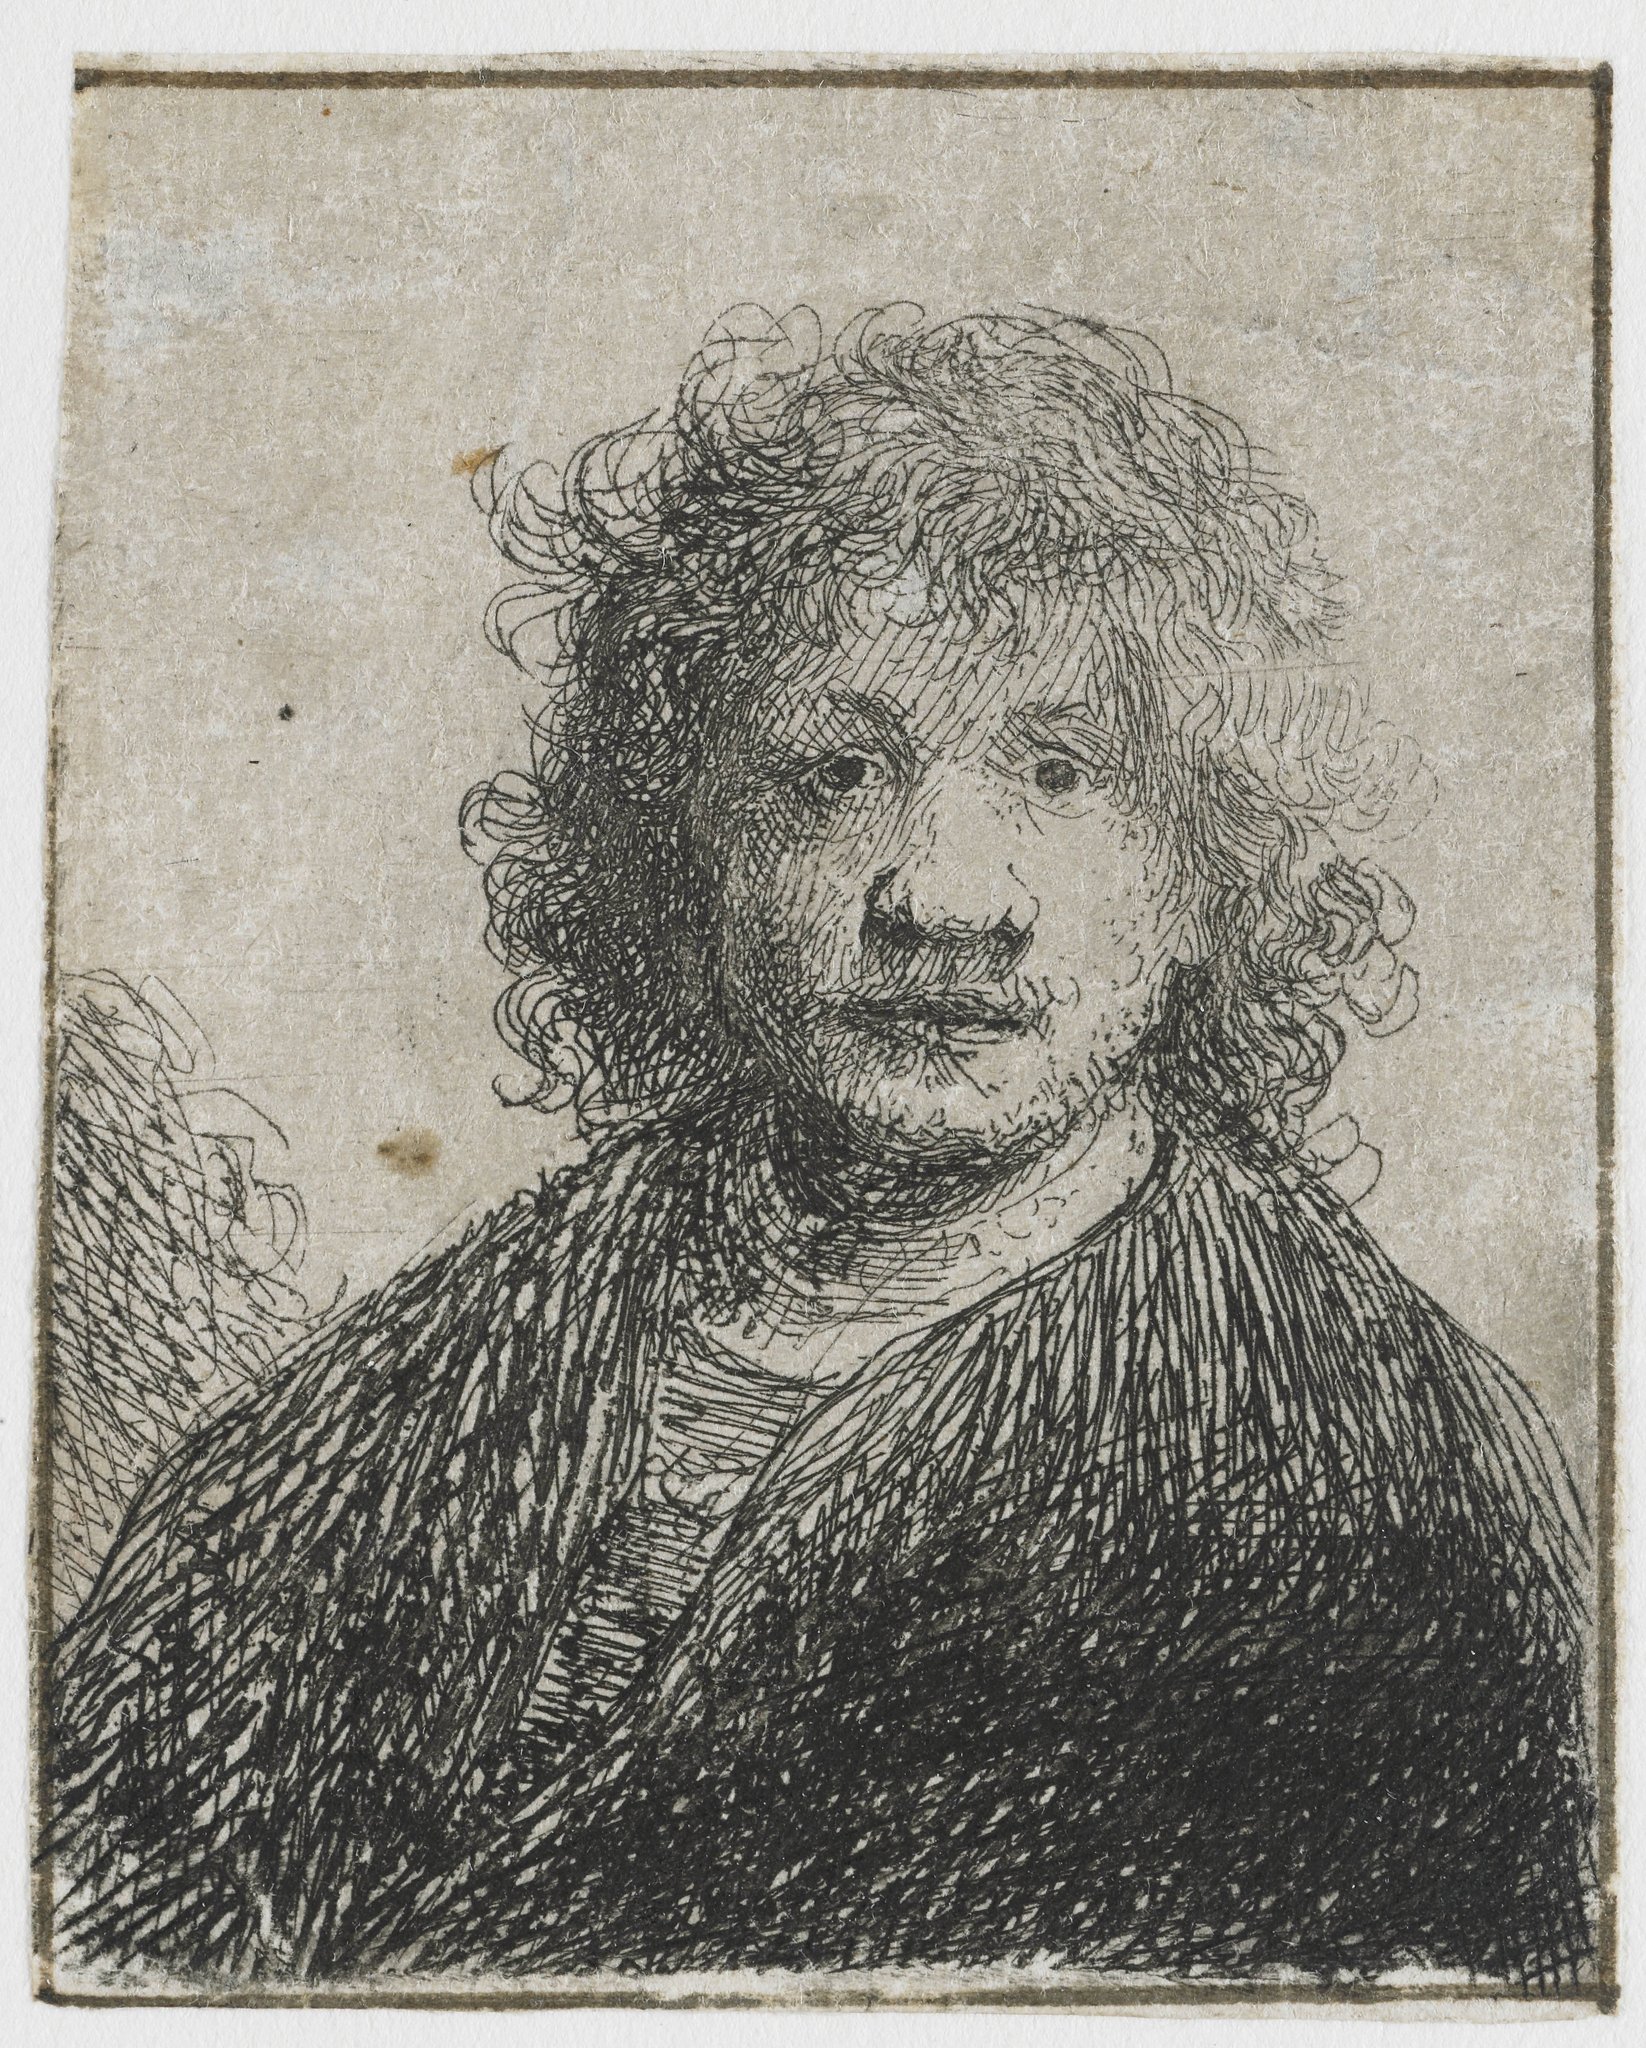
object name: print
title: Self-portrait with a broad nose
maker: rembrandt van rijn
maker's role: draughtsman, painter, print maker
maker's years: 1606-1669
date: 1628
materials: ink, paper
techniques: etching, intaglio, pen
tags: leiden, amsterdam, painter, print maker, rembrandt van rijn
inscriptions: collector's mark: Lugt 240, collector's mark: Lugt 2228 a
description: Rembrandt was fascinated by the effects of light. This is also clear in his etchings, for instance in these diminutive self-portraits in which his face is mostly half cast in shadow. In the version with a fur cap, we can see that this head covering was added only at a later stage. He began the etching with a bare head: his hair is still visible through the cap.